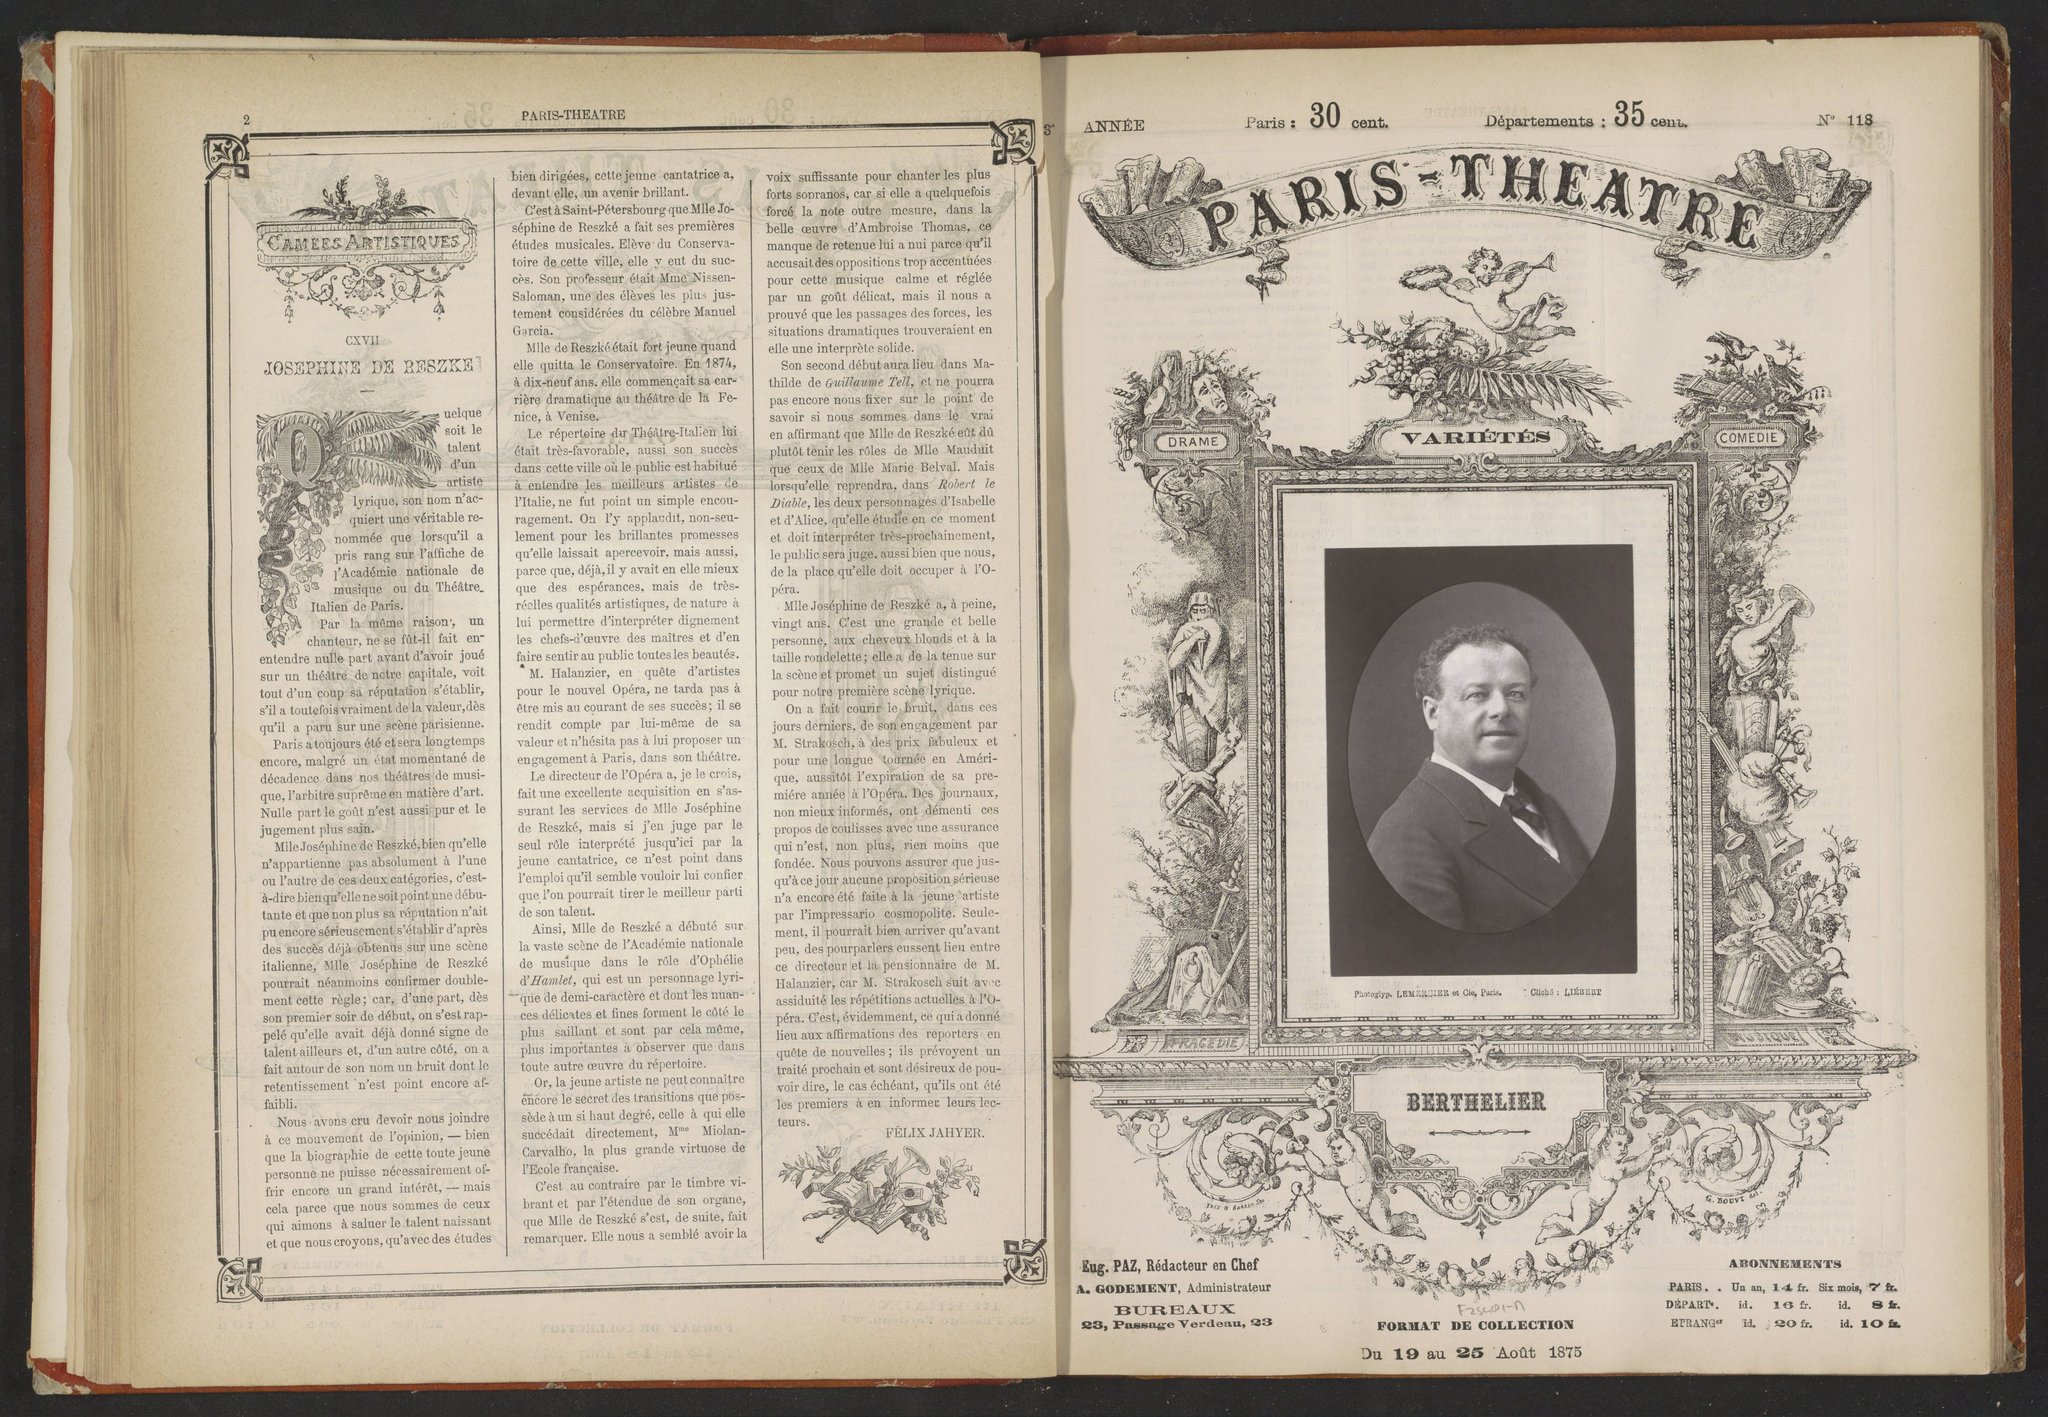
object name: page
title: Portret van Jean Berthelier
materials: paper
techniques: woodburytype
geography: paris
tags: paris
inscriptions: number: ‘No 118’, inscription: ‘Du 19 au 25 Août 1875’